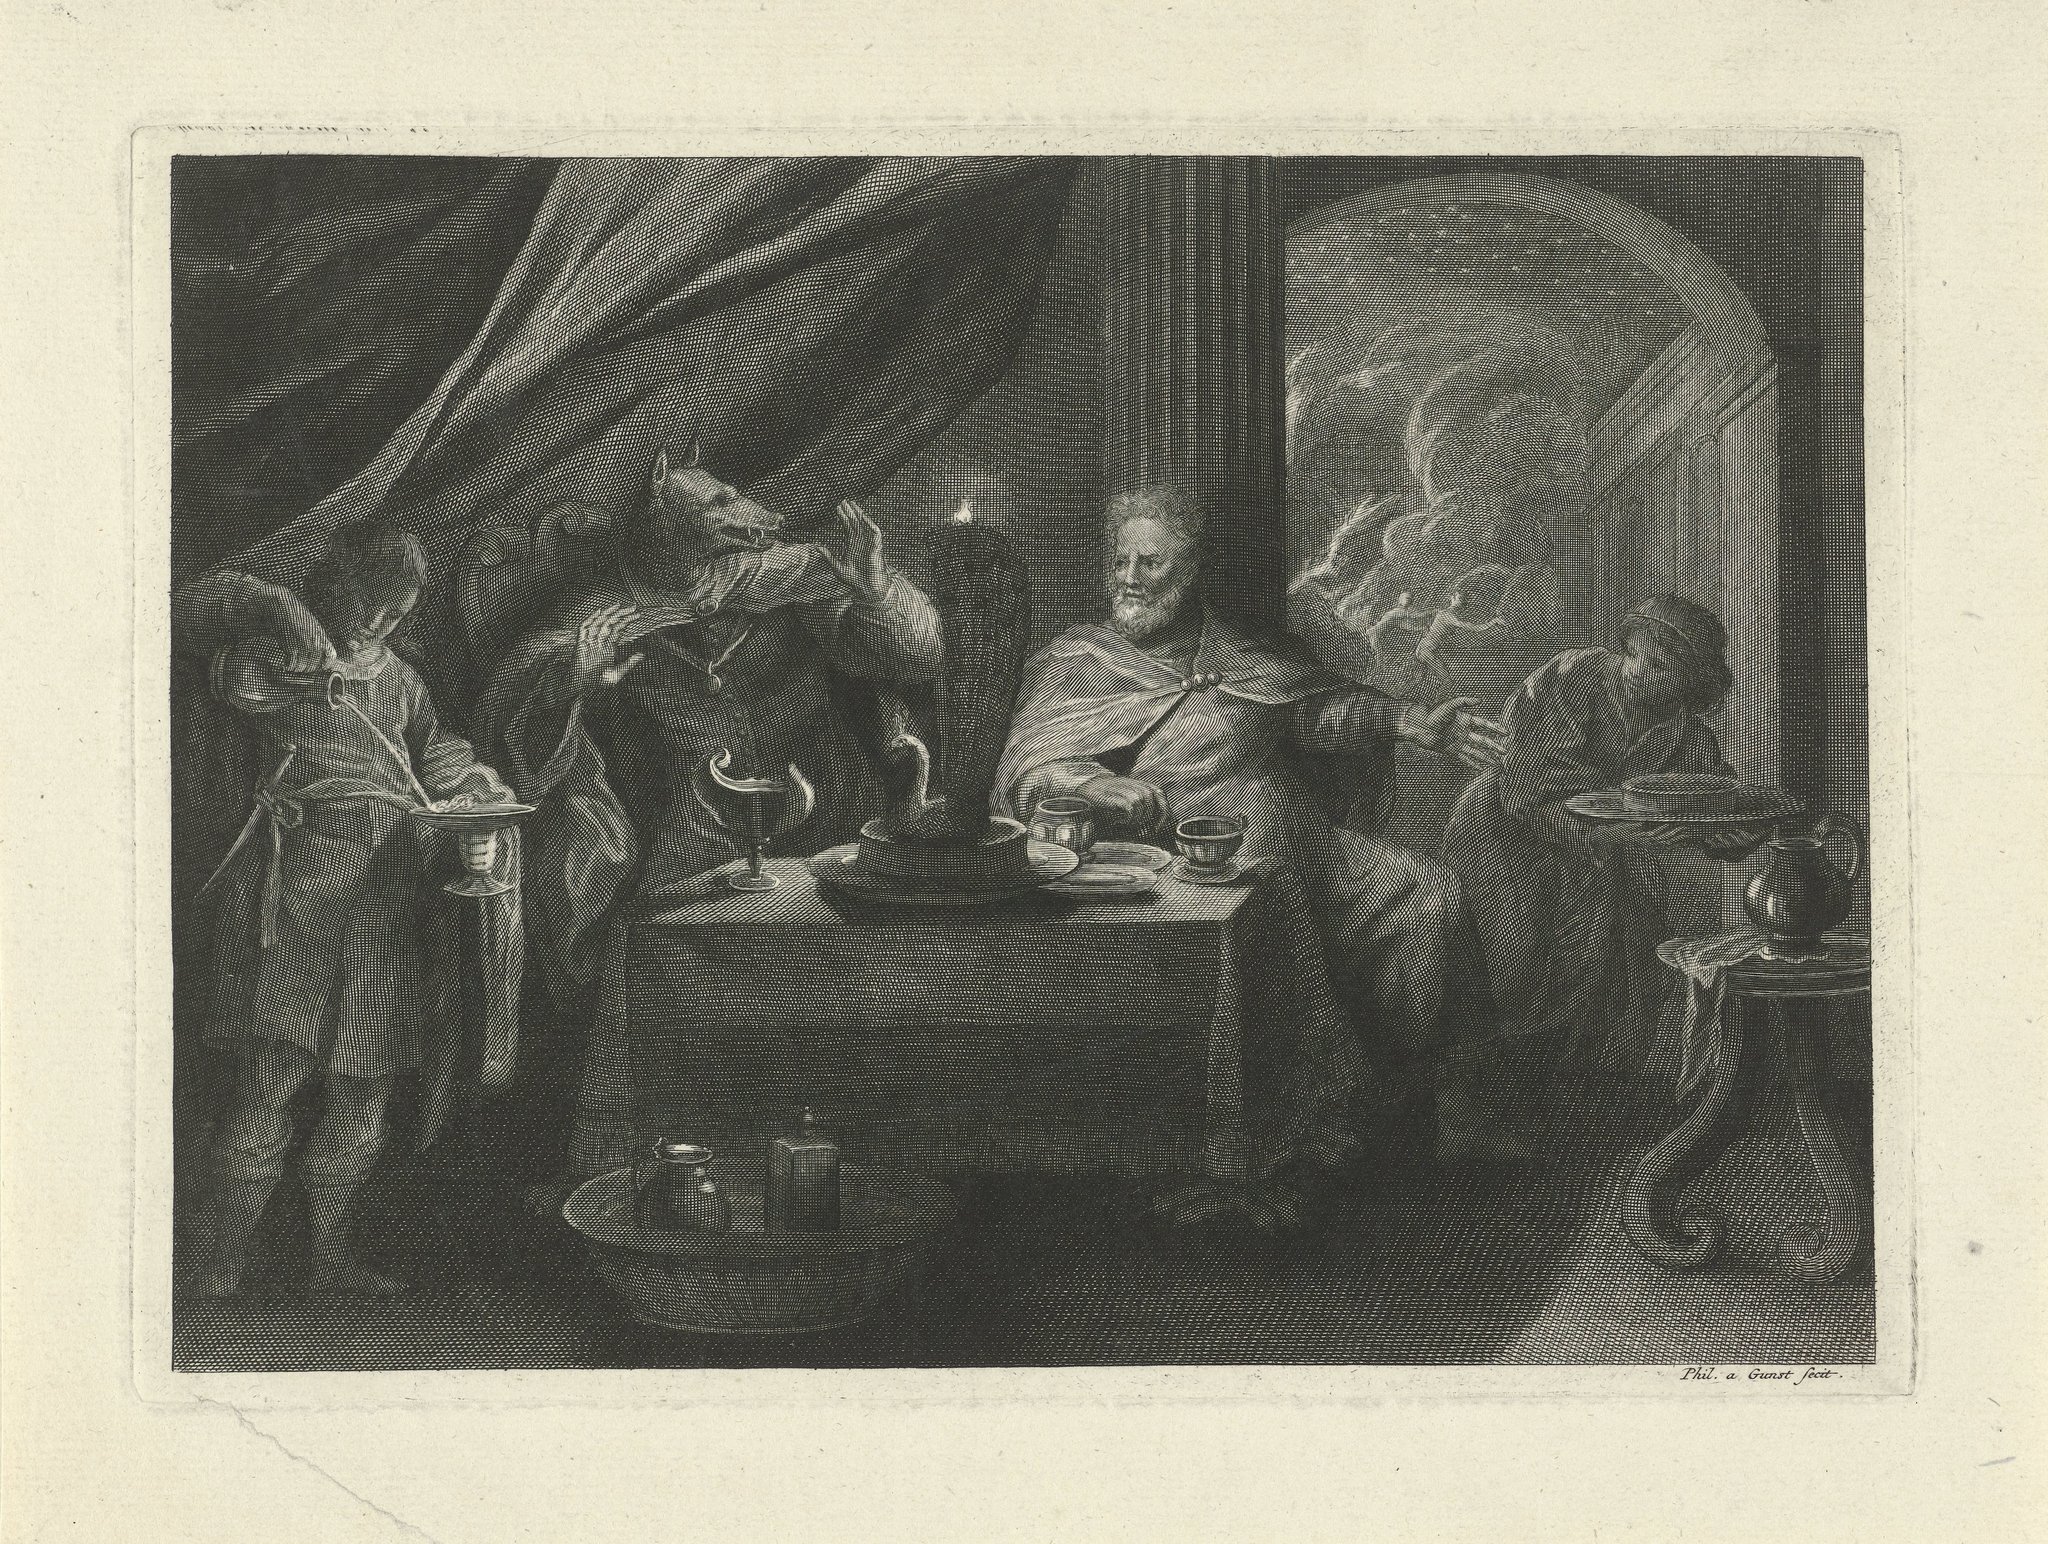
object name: print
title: Jupiter verandert koning Lycaon in een wolf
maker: philip van gunst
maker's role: print maker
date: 1685-1732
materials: paper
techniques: engraving, etching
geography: amsterdam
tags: lycaon changed into a wolf: jupiter changes lycaon into a wolf as punishment for offering the god, who is sitting at table, human flesh to eat; lycaon's house is struck with lightning (ovid, metamorphoses i 237)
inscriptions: collector's mark: Lugt 2228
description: Op de voorgrond verandert Jupiter koning Lycaon in een wolf. Rechts op de achtergrond worden Lycaons vijftig zonen door bliksem getroffen. Lycaon had getracht Jupiter te bedriegen door diens zoon Arcas te slachten en hem als avondmaal aan te bieden.